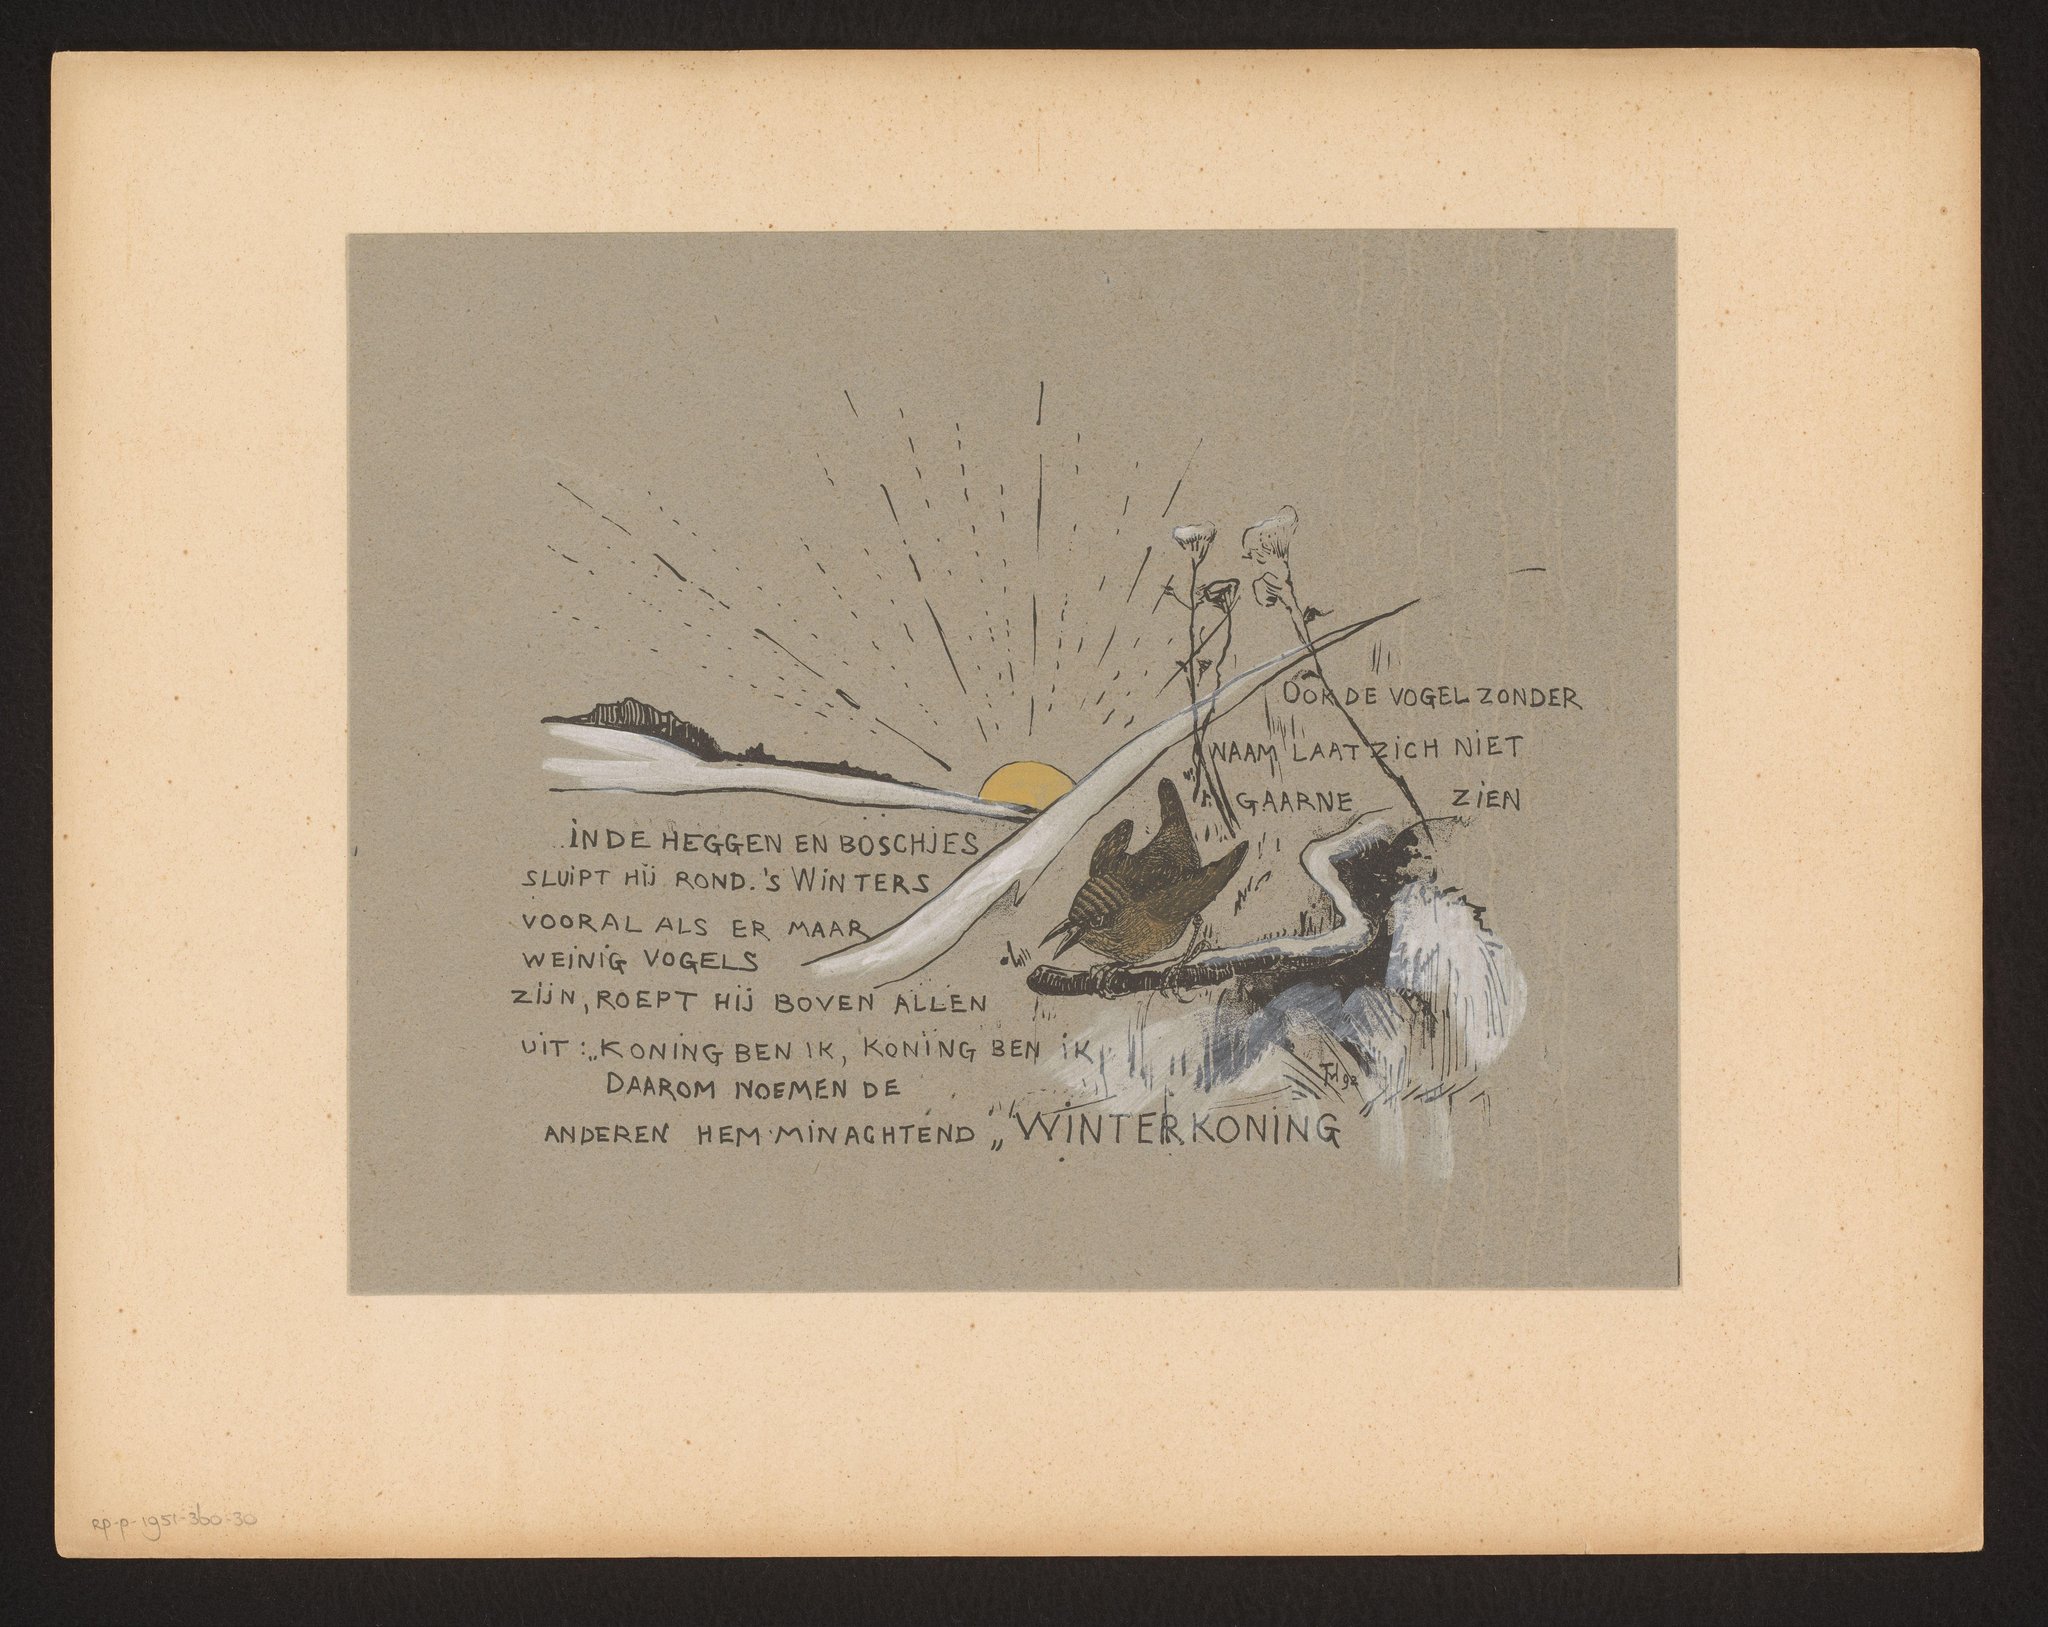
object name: print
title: Hoe de vogels aan een koning kwamen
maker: theo van hoytema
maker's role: draughtsman, painter, print maker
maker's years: 1863-1917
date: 1892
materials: paper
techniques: hand coloring, lithograph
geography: the hague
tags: song-birds: wren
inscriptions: date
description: Zowel tekst als afbeelding zijn gelithografeerd.